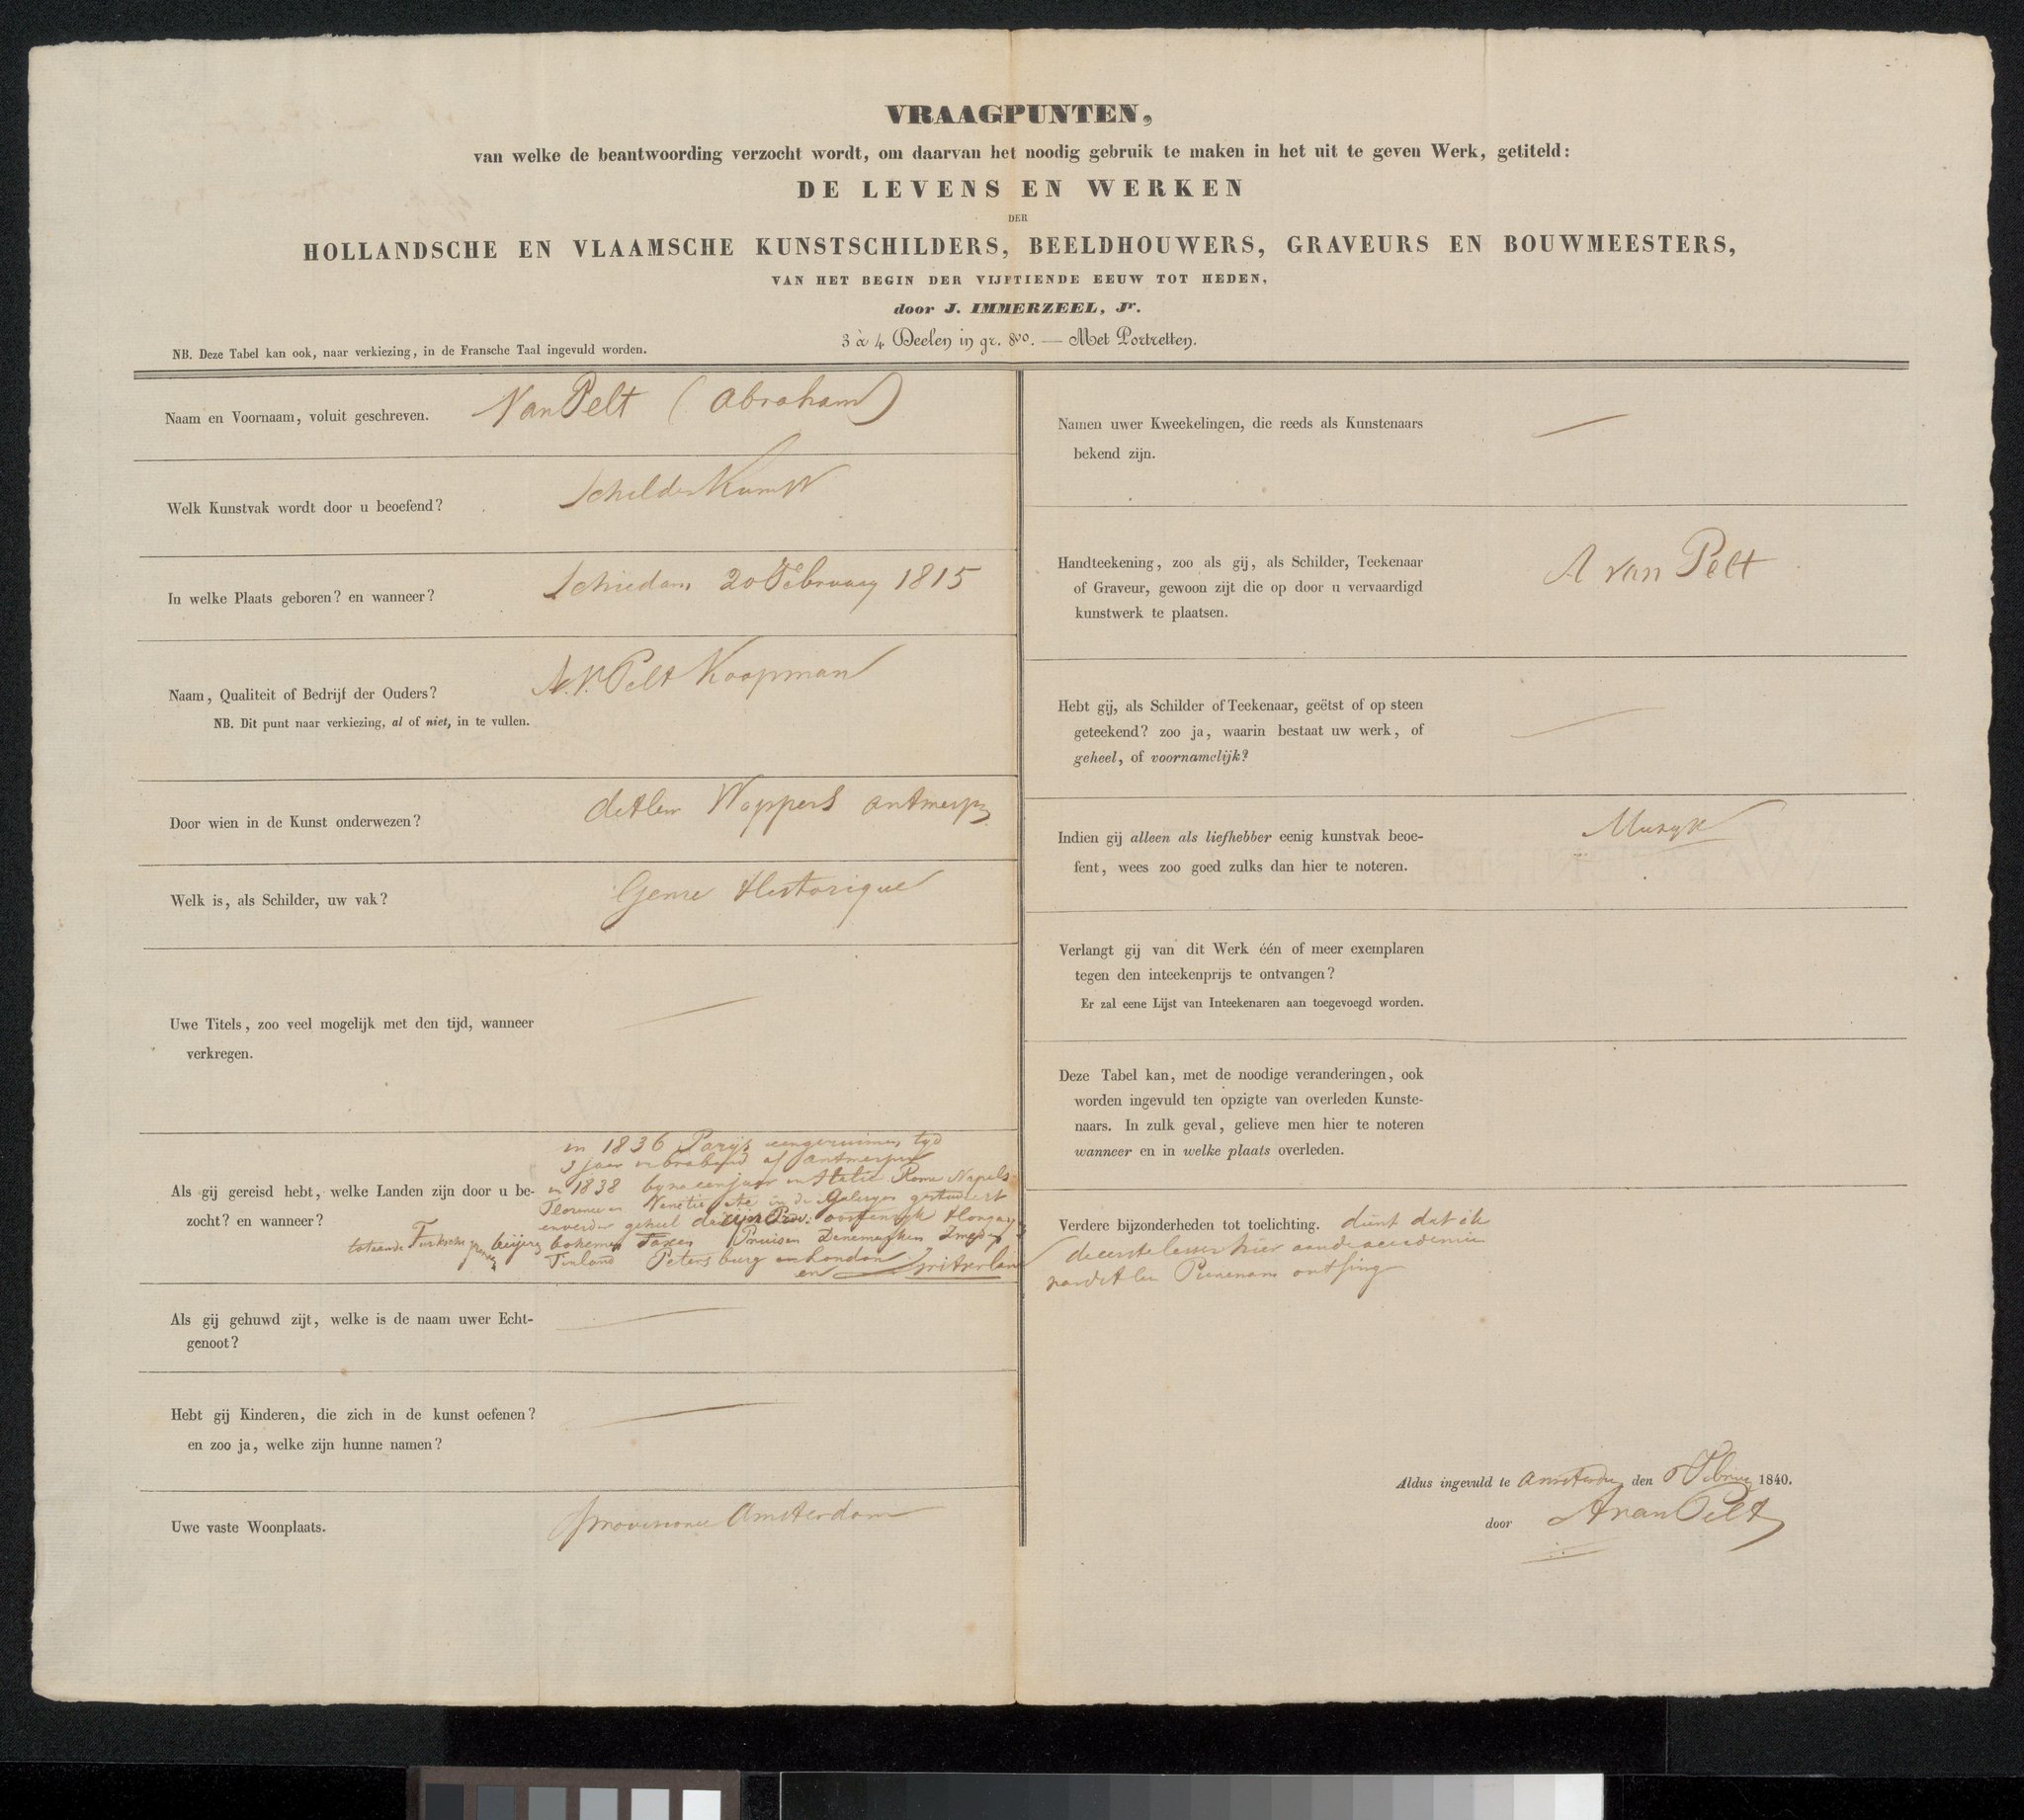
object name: questionnaire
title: Enquêteformulier ingevuld door Abraham van Pelt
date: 1802-1840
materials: ink, paper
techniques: pen, printing, writing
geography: amsterdam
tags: nijmegen, print maker, draughtsman, abraham van pelt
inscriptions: inscription: ‘Vraagpunten,/ van welke de beantwoording verzocht wordt, om daarvan het noodig gebruik te maken in het uit te geven Werk, getiteld: De levens en werken/ der Hollandsche en Vlaamsche kunstschilders, beeldhouwers,/ graveurs en bouwmeesters, van het begin der vijftiende eeuw tot heden/ door J. Immerzeel, Jr.’, watermark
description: Opgenomen in: Immerzeel, J. Jr., De levens en werken der Hollandsche en Vlaamsche kunstschilders, beeldhouwers, graveurs en bouwmeesters, van het begin der vijftiende eeuw tot heden, Amsterdam: J.C. van Kesteren, 1842-1843.